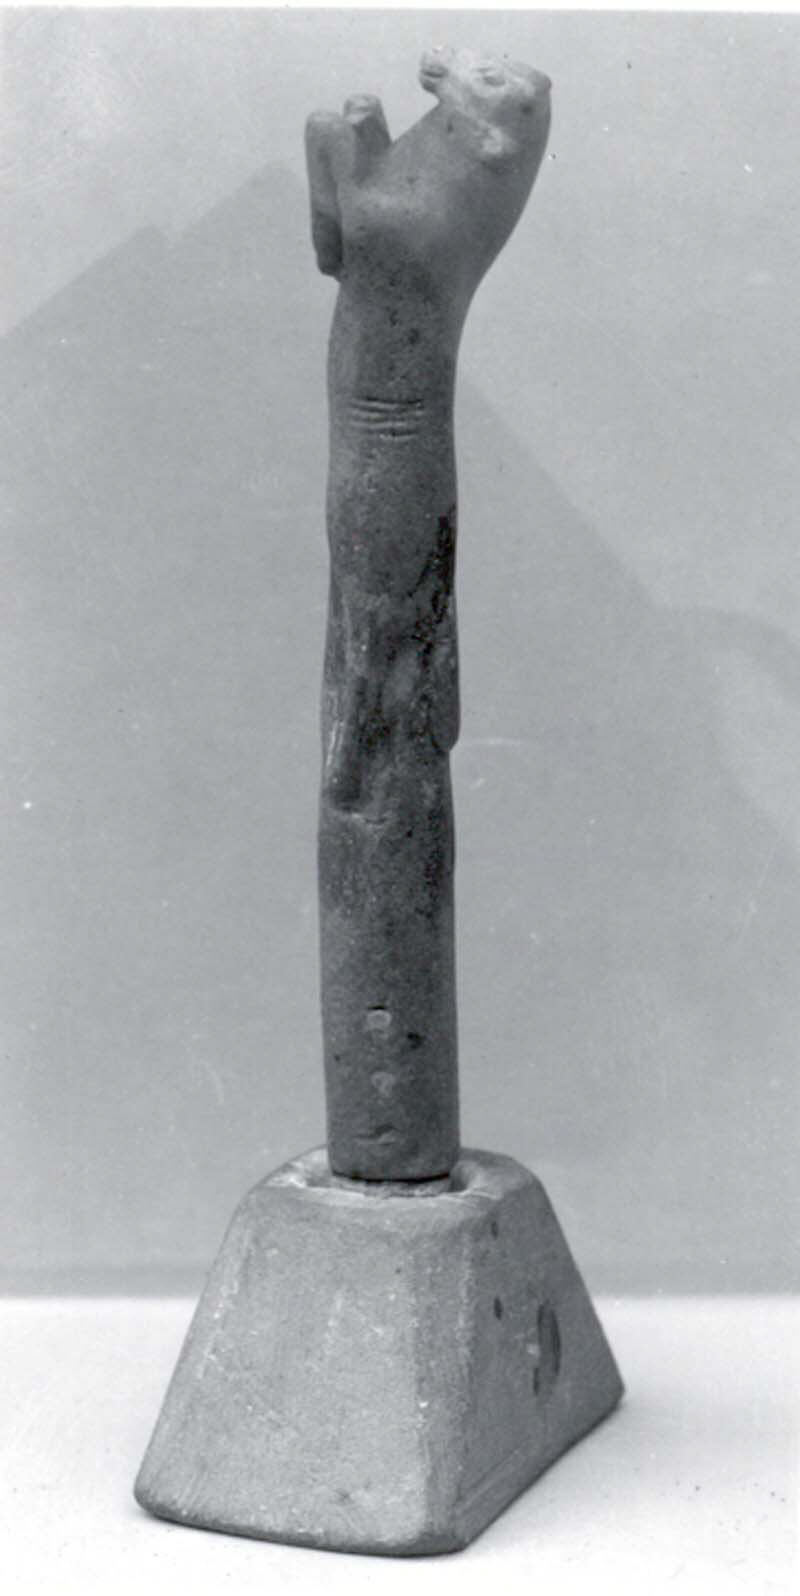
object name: whip or fly whisk handle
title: Handle of whip or fly whisk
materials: faience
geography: egypt (?)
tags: animals